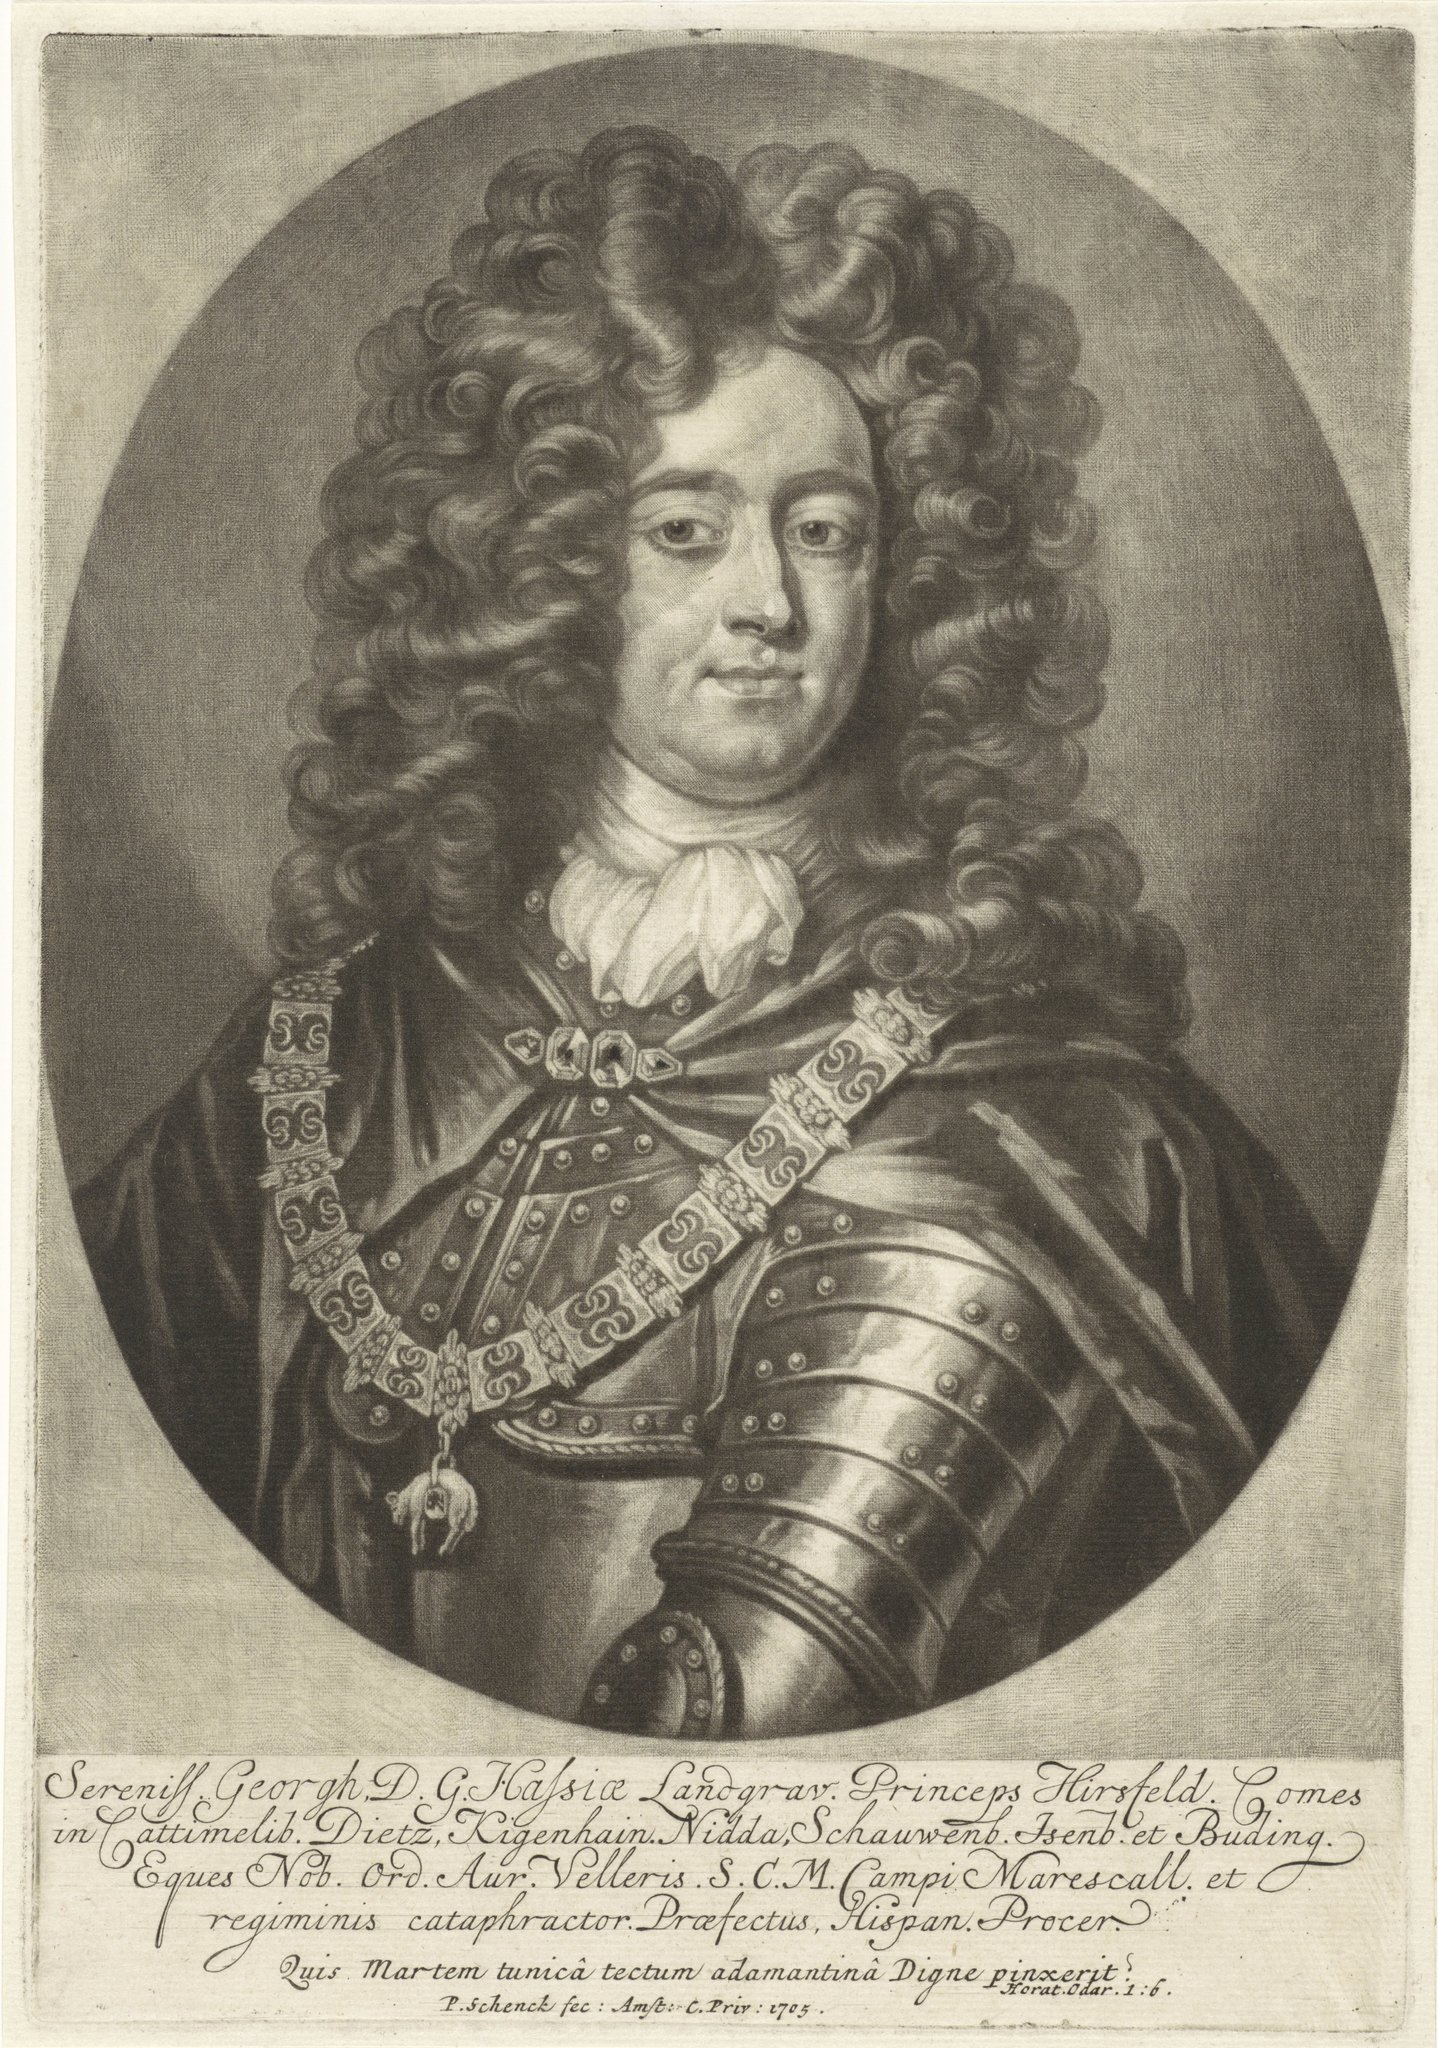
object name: print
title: Portret van George Lodewijk van Hessen-Darmstadt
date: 1705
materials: paper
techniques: engraving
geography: amsterdam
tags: armour, knighthood order of the golden fleece, wig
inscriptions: collector's mark: Lugt 2228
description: George Lodewijk, graaf van Hessen-Darmstadt, met om de hals een keten waaraan het ordeteken van de Orde van het Gulden Vlies.